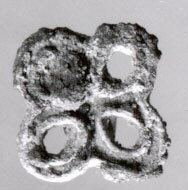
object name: stamp seal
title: Compartmented stamp seal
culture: bactria-margiana archaeological complex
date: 2333-1668 BCE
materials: copper alloy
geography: bactria-margiana